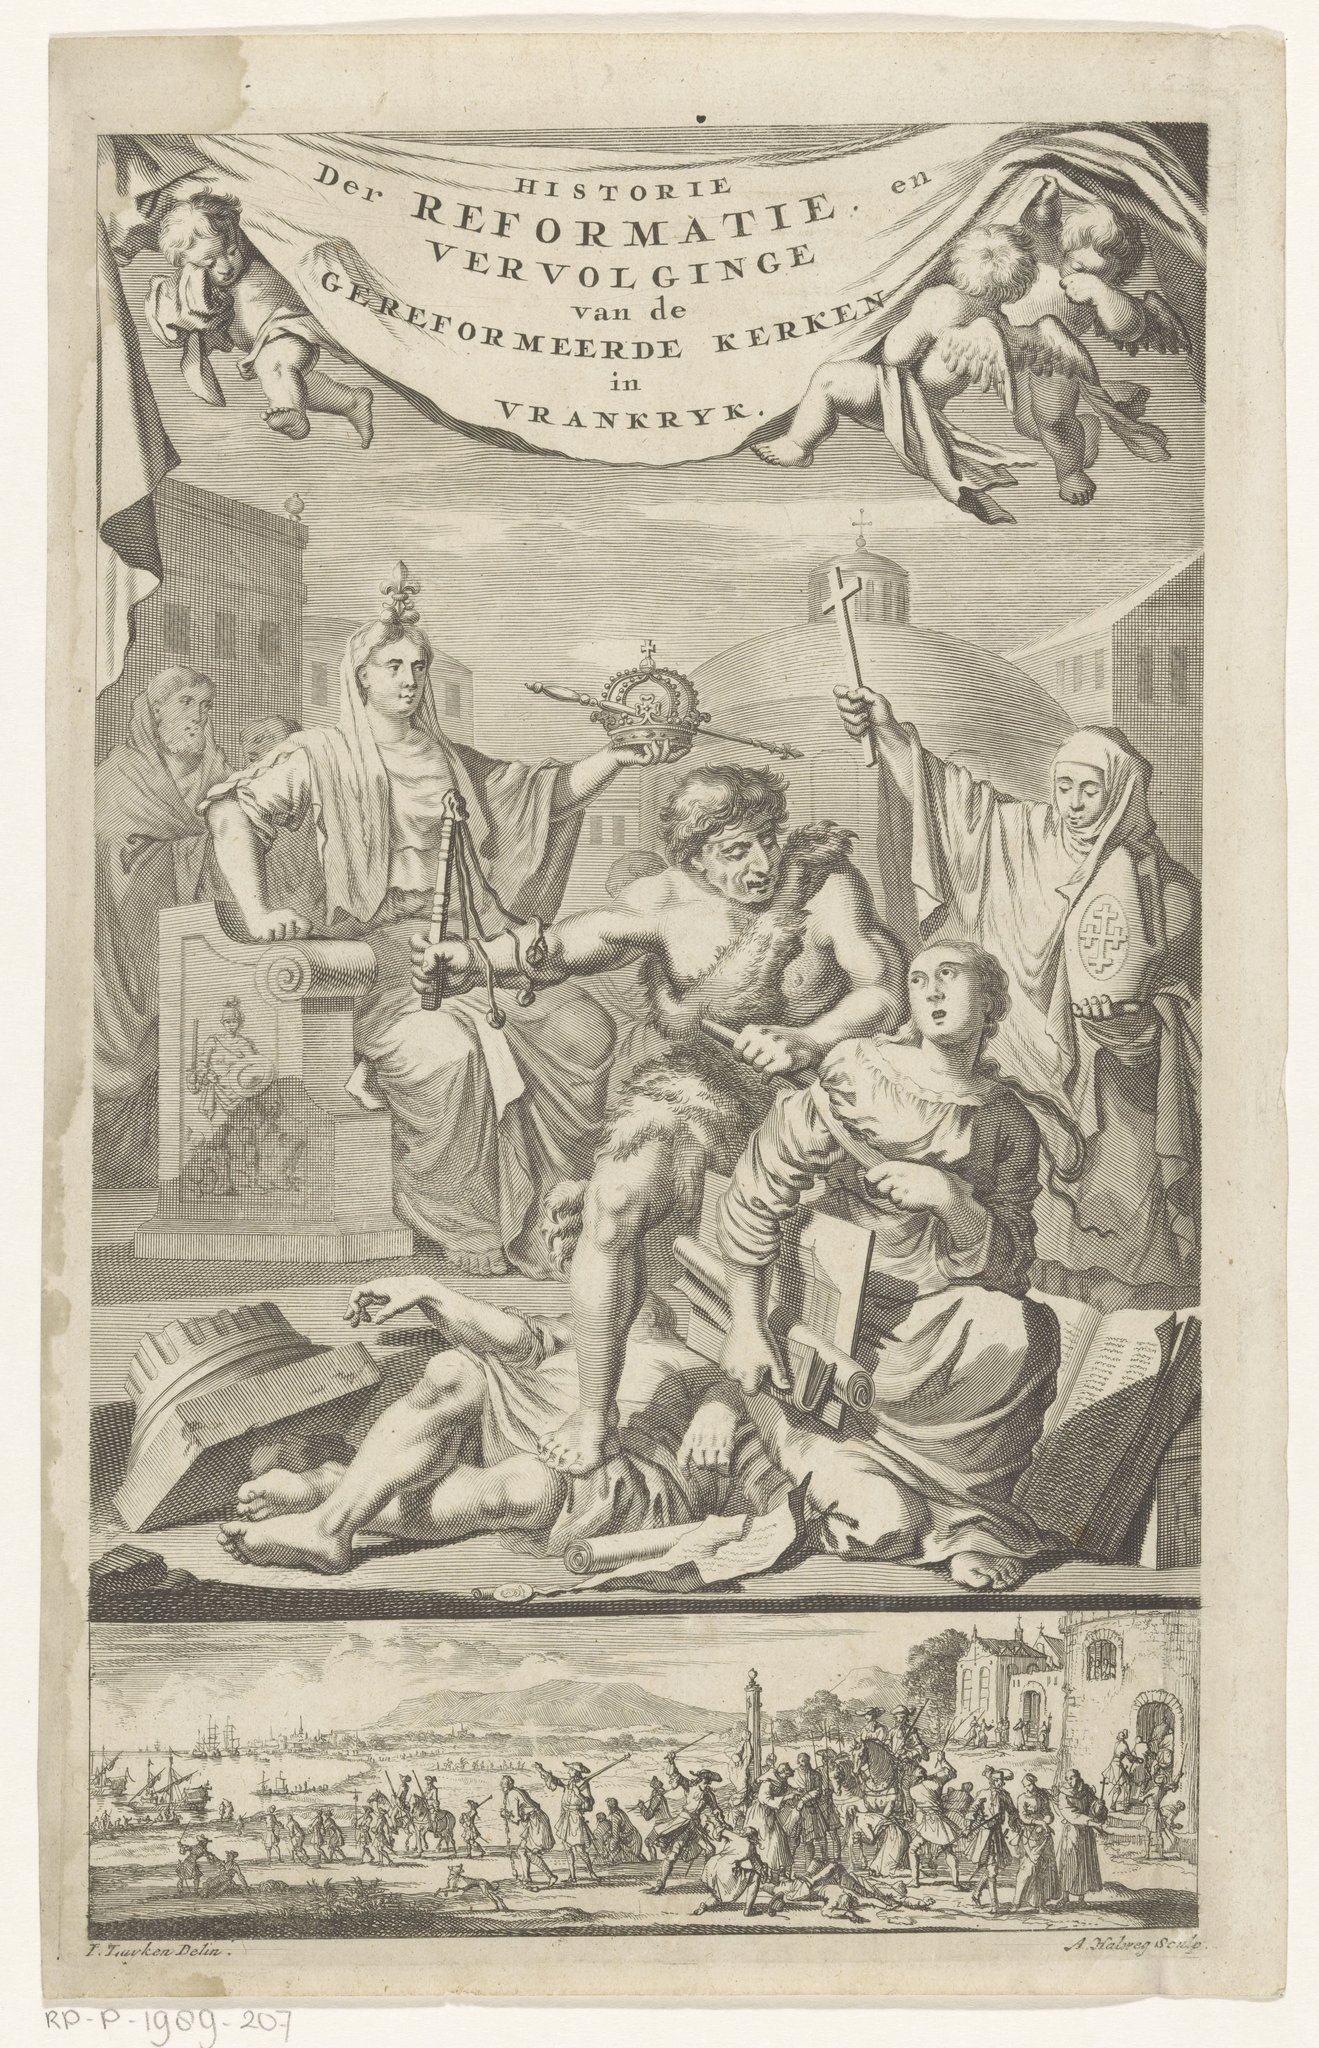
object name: print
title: Historie Der reformatie, en vervolginge van de gereformeerde kerken in Vrankryk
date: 1696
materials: paper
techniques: engraving, etching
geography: amsterdam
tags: persecution of believers, the roman catholic church vs. protestantism; (reformation and counter reformation)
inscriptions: collector's mark: Lugt 2228, collector's mark: Lugt 2228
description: De personificatie van de Franse Hervormde Kerk, de Hugenoten, wordt aangevallen door een wildeman met een gesel. Dit vindt plaats onder goedkeuring door personificaties van het Franse koningschap en de Franse Katholieke Kerk. Hieronder een voorstelling van de vervolging en verdrijving van de Hugenoten.